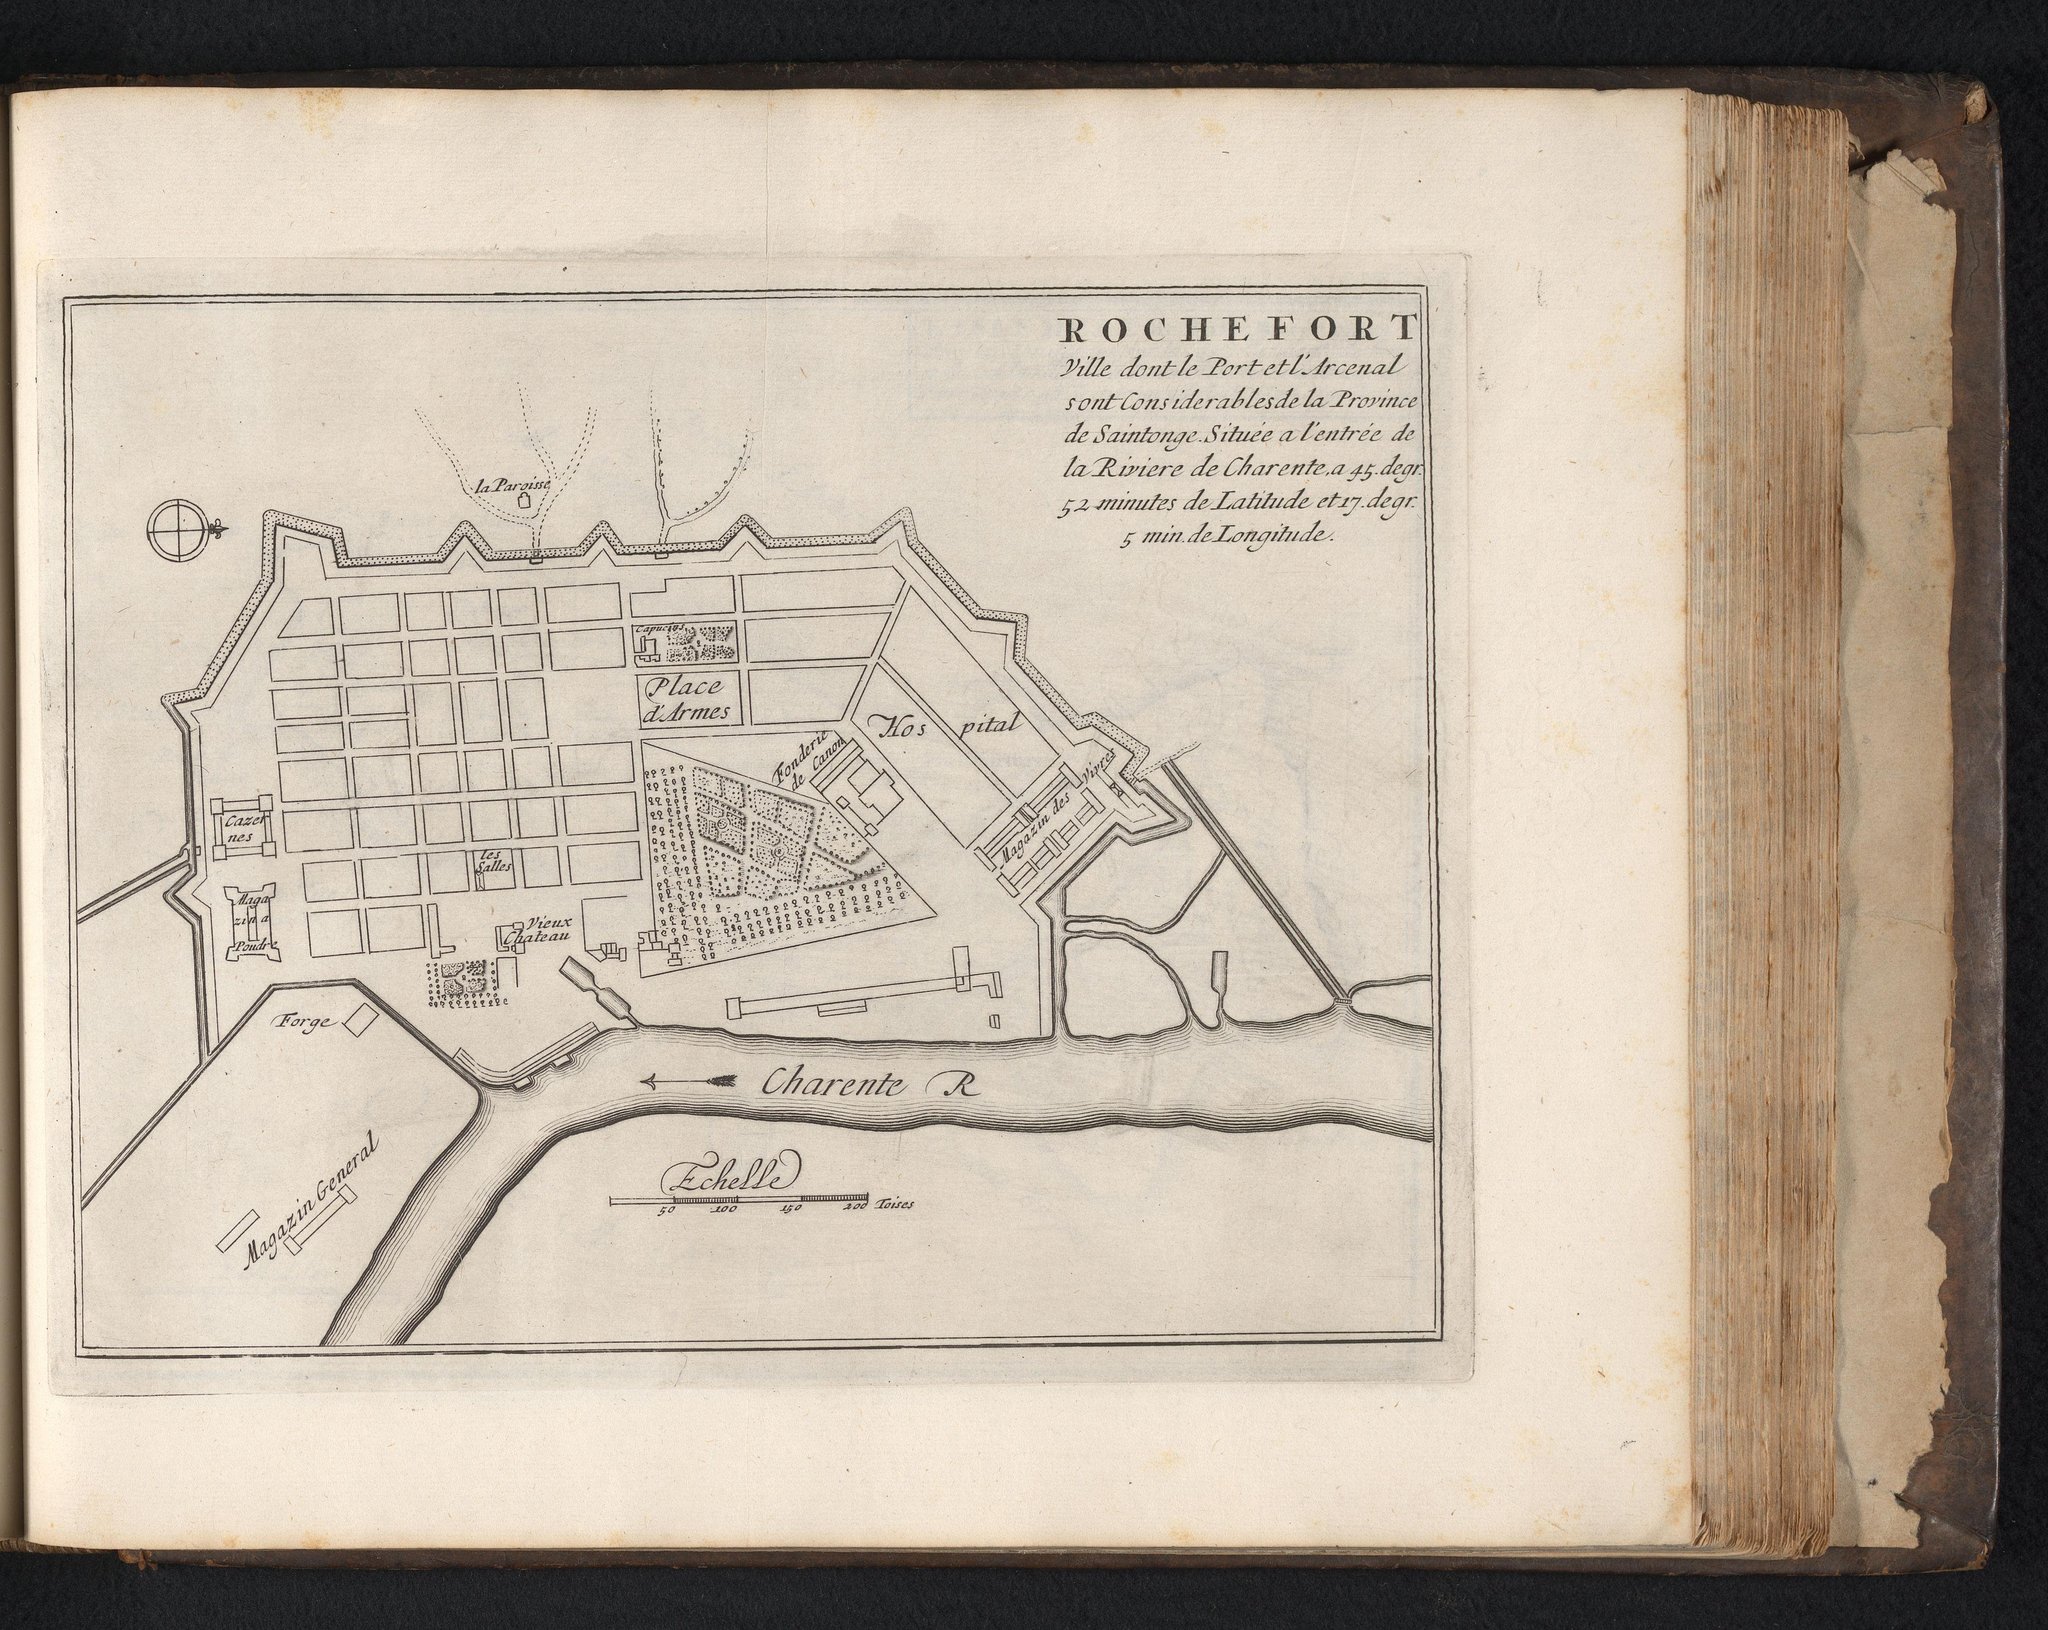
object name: map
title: Plattegrond van Rochefort, ca. 1695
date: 1695-1697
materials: paper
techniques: etching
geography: france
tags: fortress, maps of cities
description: Plattegrond van de versterkingen om de Franse stad Rochefort. Onderdeel van het achtste deel (1697) van het prentwerk waarin gebundeld zijn de acht delen van Les forces de l'Europe uitgegeven tussen 1693-1697. Het prentwerk bestaat uit 175 platen met plannen (afkomstig van Sébastien Le Prestre, Seigneur de Vauban) van vermaarde sterke steden en vestingen in de Negenjarige Oorlog. Titel en opschriften in het Frans.